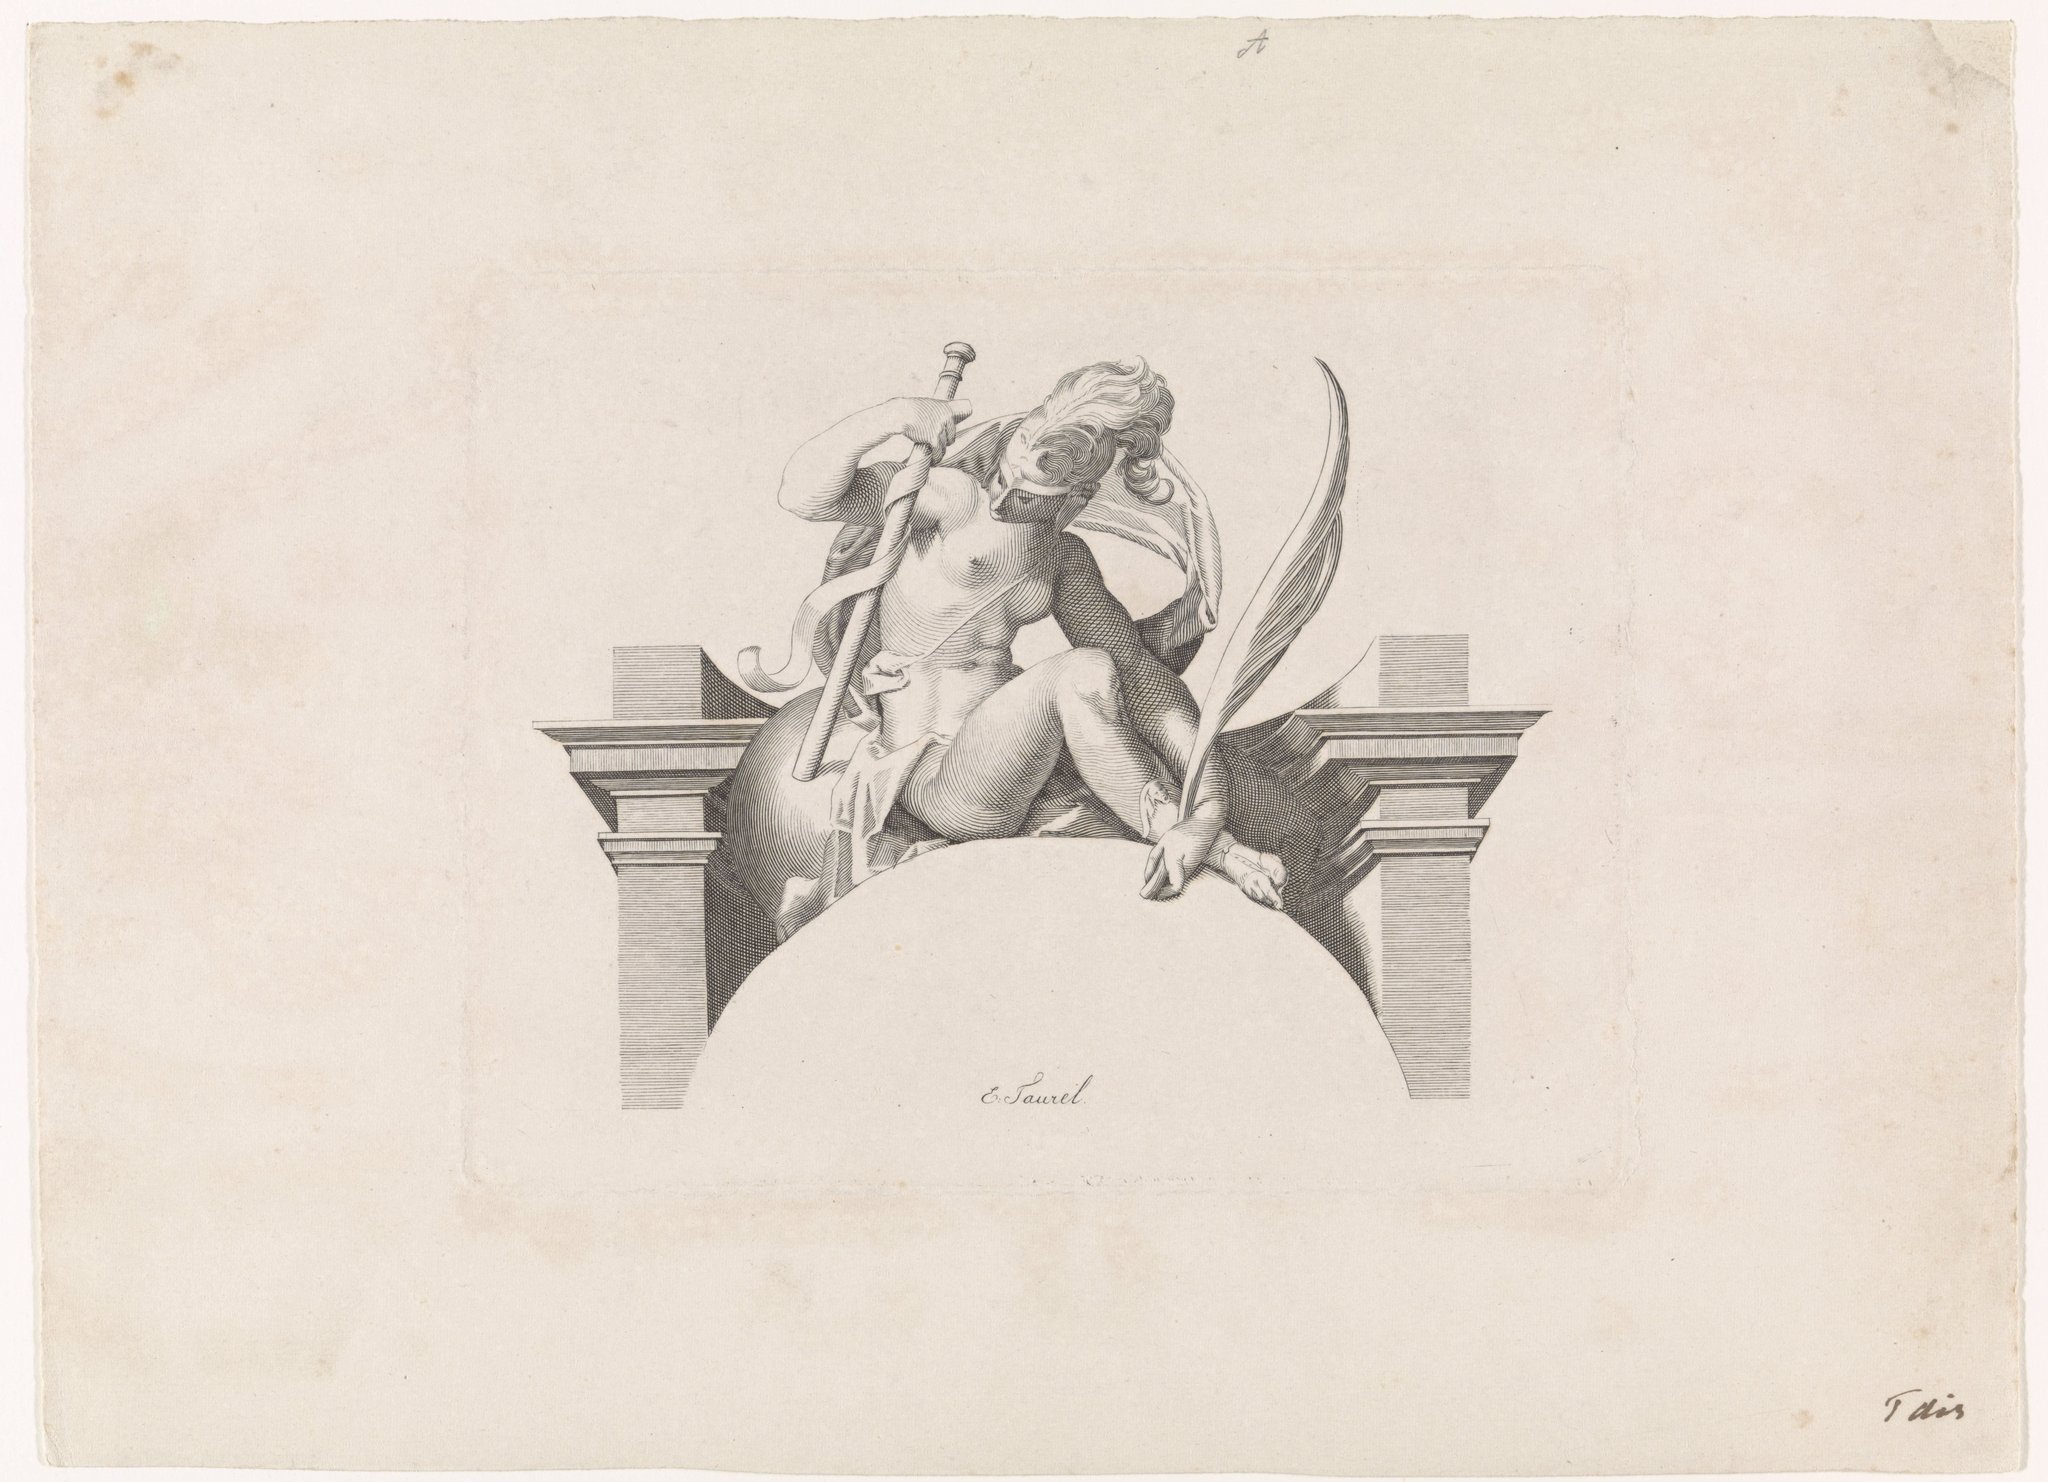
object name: print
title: Allegorische vrouwenfiguur op een bol in een nis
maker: edouard taurel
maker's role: draughtsman, print maker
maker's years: 1824-1892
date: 1834-1892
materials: paper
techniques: engraving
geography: amsterdam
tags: allegorical representation of human figure of ideal proportions - aa - female human figure of ideal proportions; 'bellezza feminile' (ripa)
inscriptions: inscription: ‘Tdir’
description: Allegorische naakte vrouwenfiguur zit op een bol in een nis. In haar handen een staf en een palmtak.